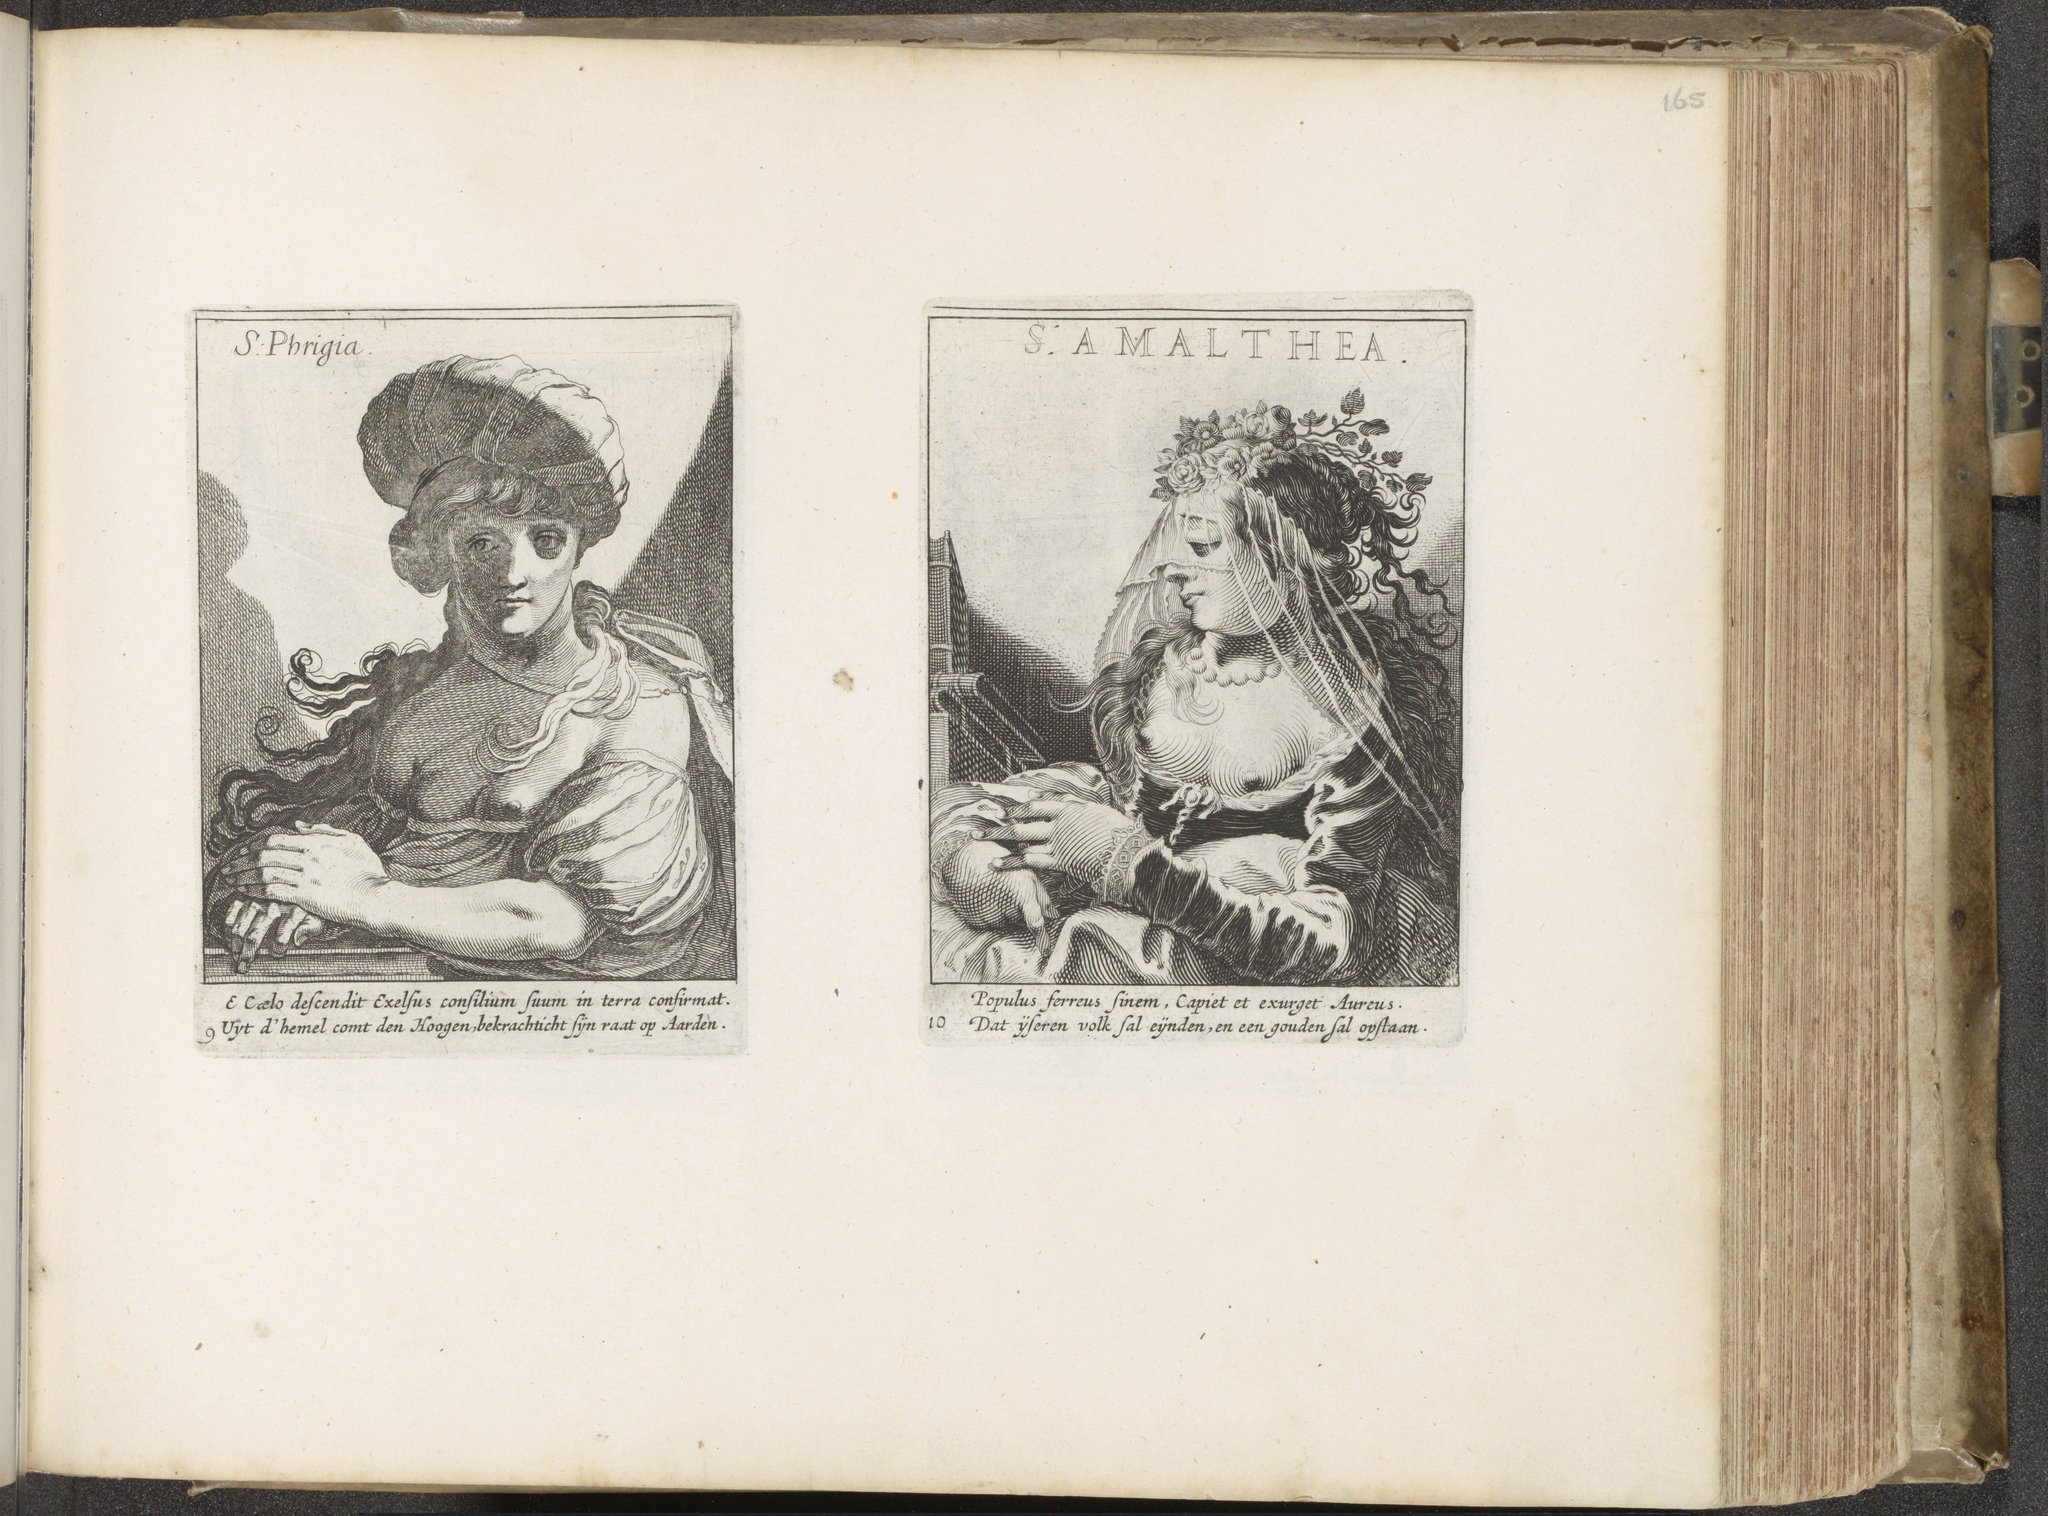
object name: print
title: Sibille van Frygië / Sibille van Amalthea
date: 1580-1628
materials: paper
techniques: engraving, etching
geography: amsterdam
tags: sibyls (with name)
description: Twee voorstellingen op een albumblad. Links de Sibille van Frygië met lange haren en een soort van tulband. Ze heeft haar handen over elkaar geslagen. Rechts de Sibille van Amalthea met sluier en bloemen. Naast haar liggen enkele boeken. In de ondermarge van beide voorstellingen een tekstregel in het Latijn en het Nederlands. Het blad maakt deel uit van een album.